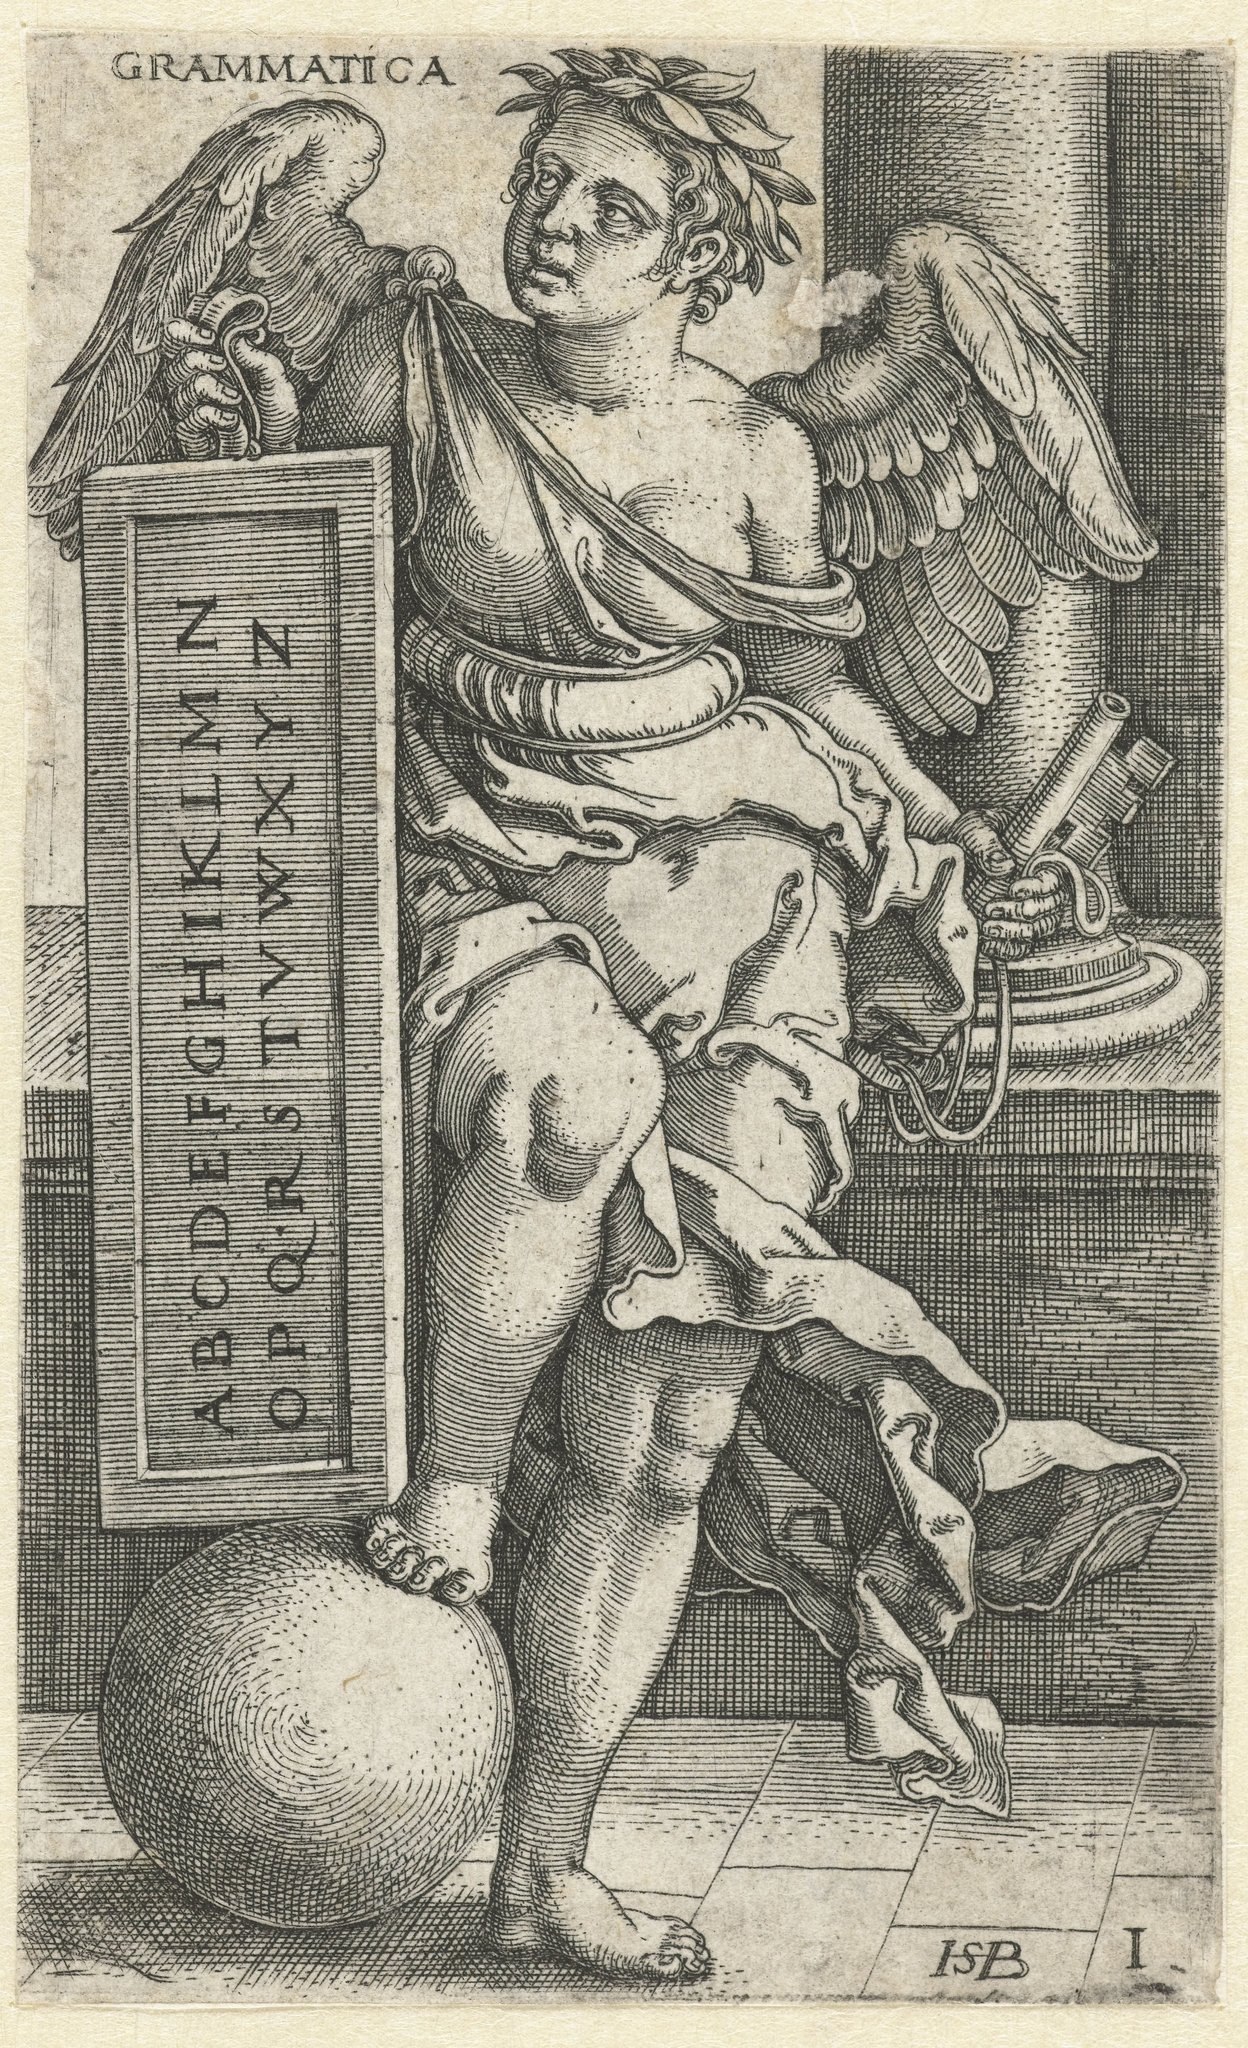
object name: print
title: Zeven Vrije Kunsten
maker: hans sebald beham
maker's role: designer, draughtsman, print maker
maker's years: 1500-1550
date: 1510-1550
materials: paper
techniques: engraving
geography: germany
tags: 'grammatica' (~ trivium); 'grammatica' (ripa)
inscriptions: collector's mark: Lugt 2228a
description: Gevleugelde vrouw als personificatie van Grammatica met een stenen tablet met een inscriptie van het alfabet en een sleutel